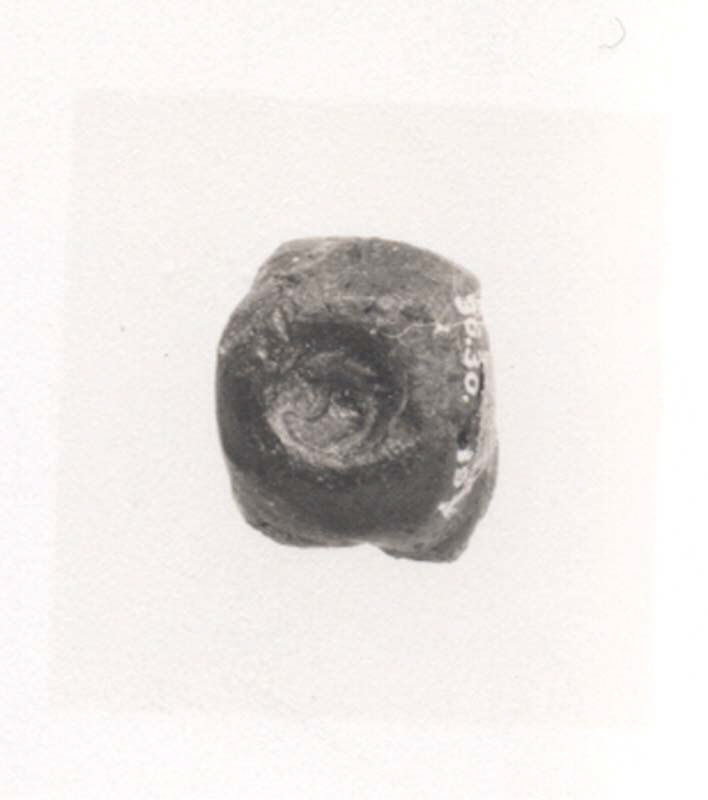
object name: sealing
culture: sasanian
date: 601-700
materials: clay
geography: iran